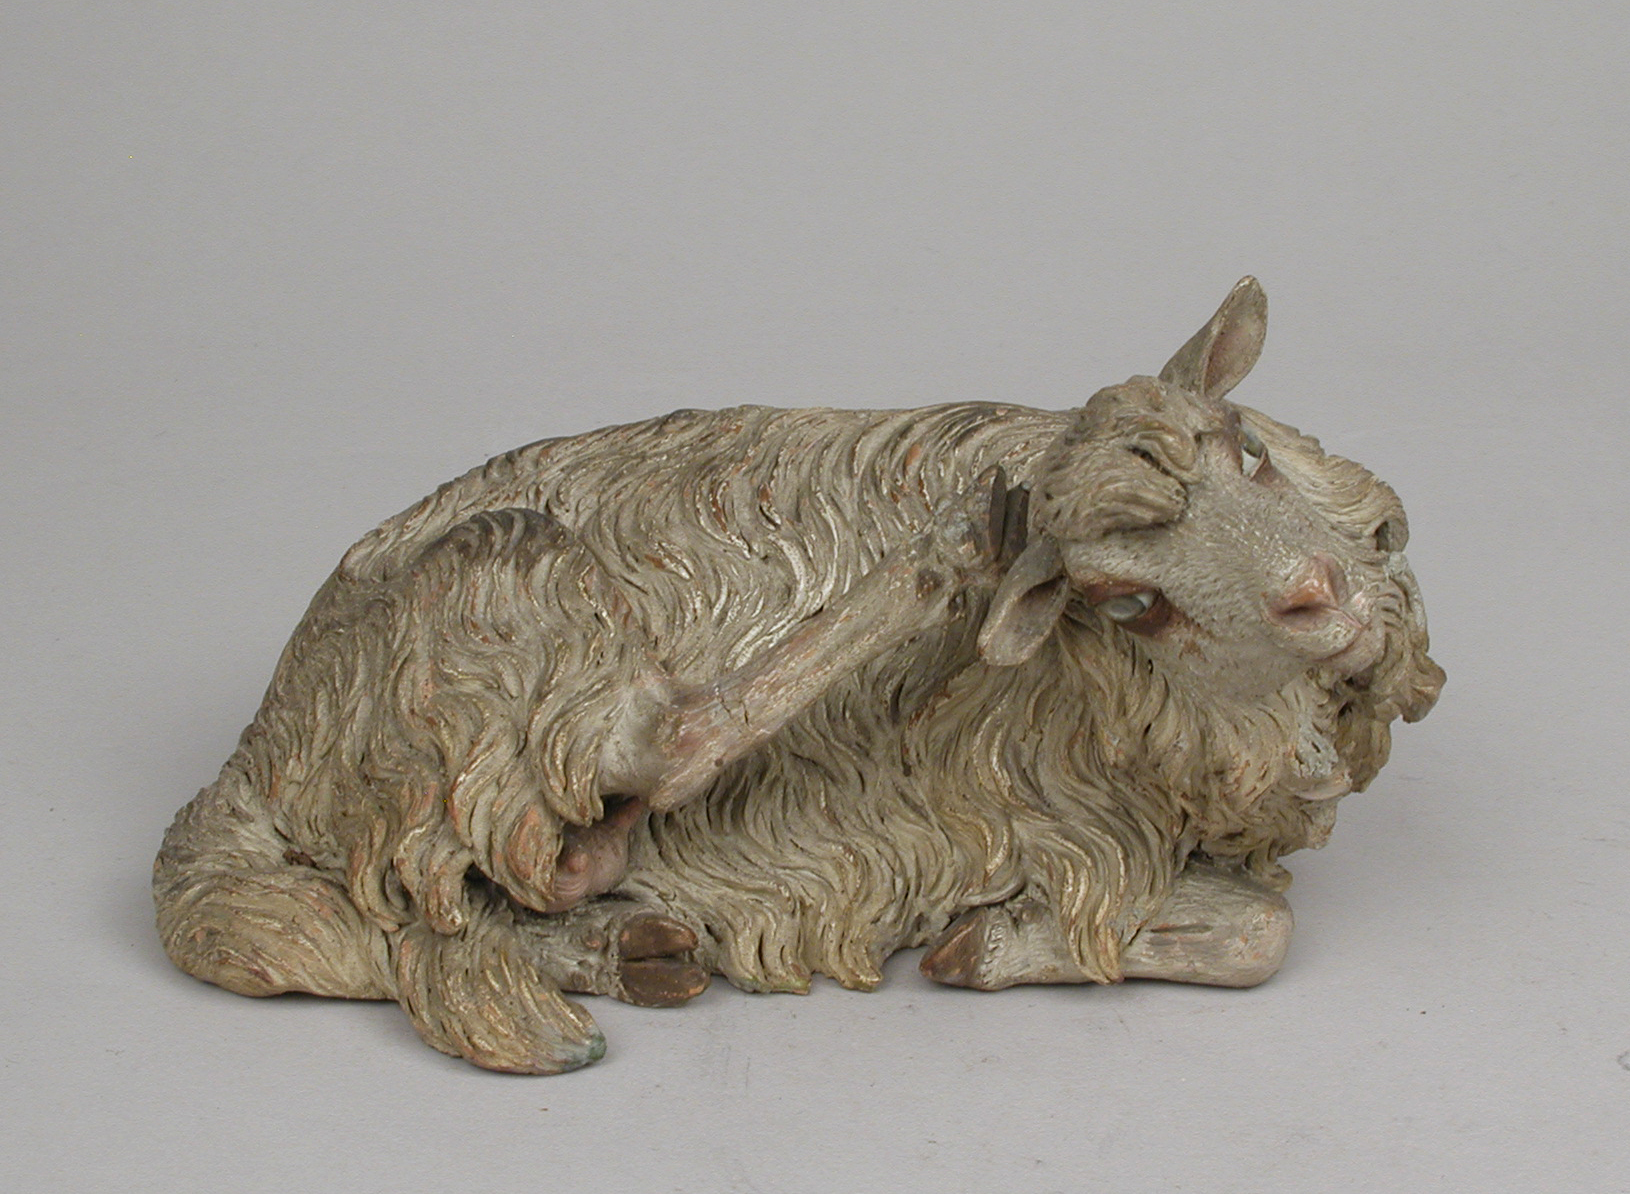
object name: crèche figure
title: Reclining sheep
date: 1701-1900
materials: terracotta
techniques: polychrome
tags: sheep